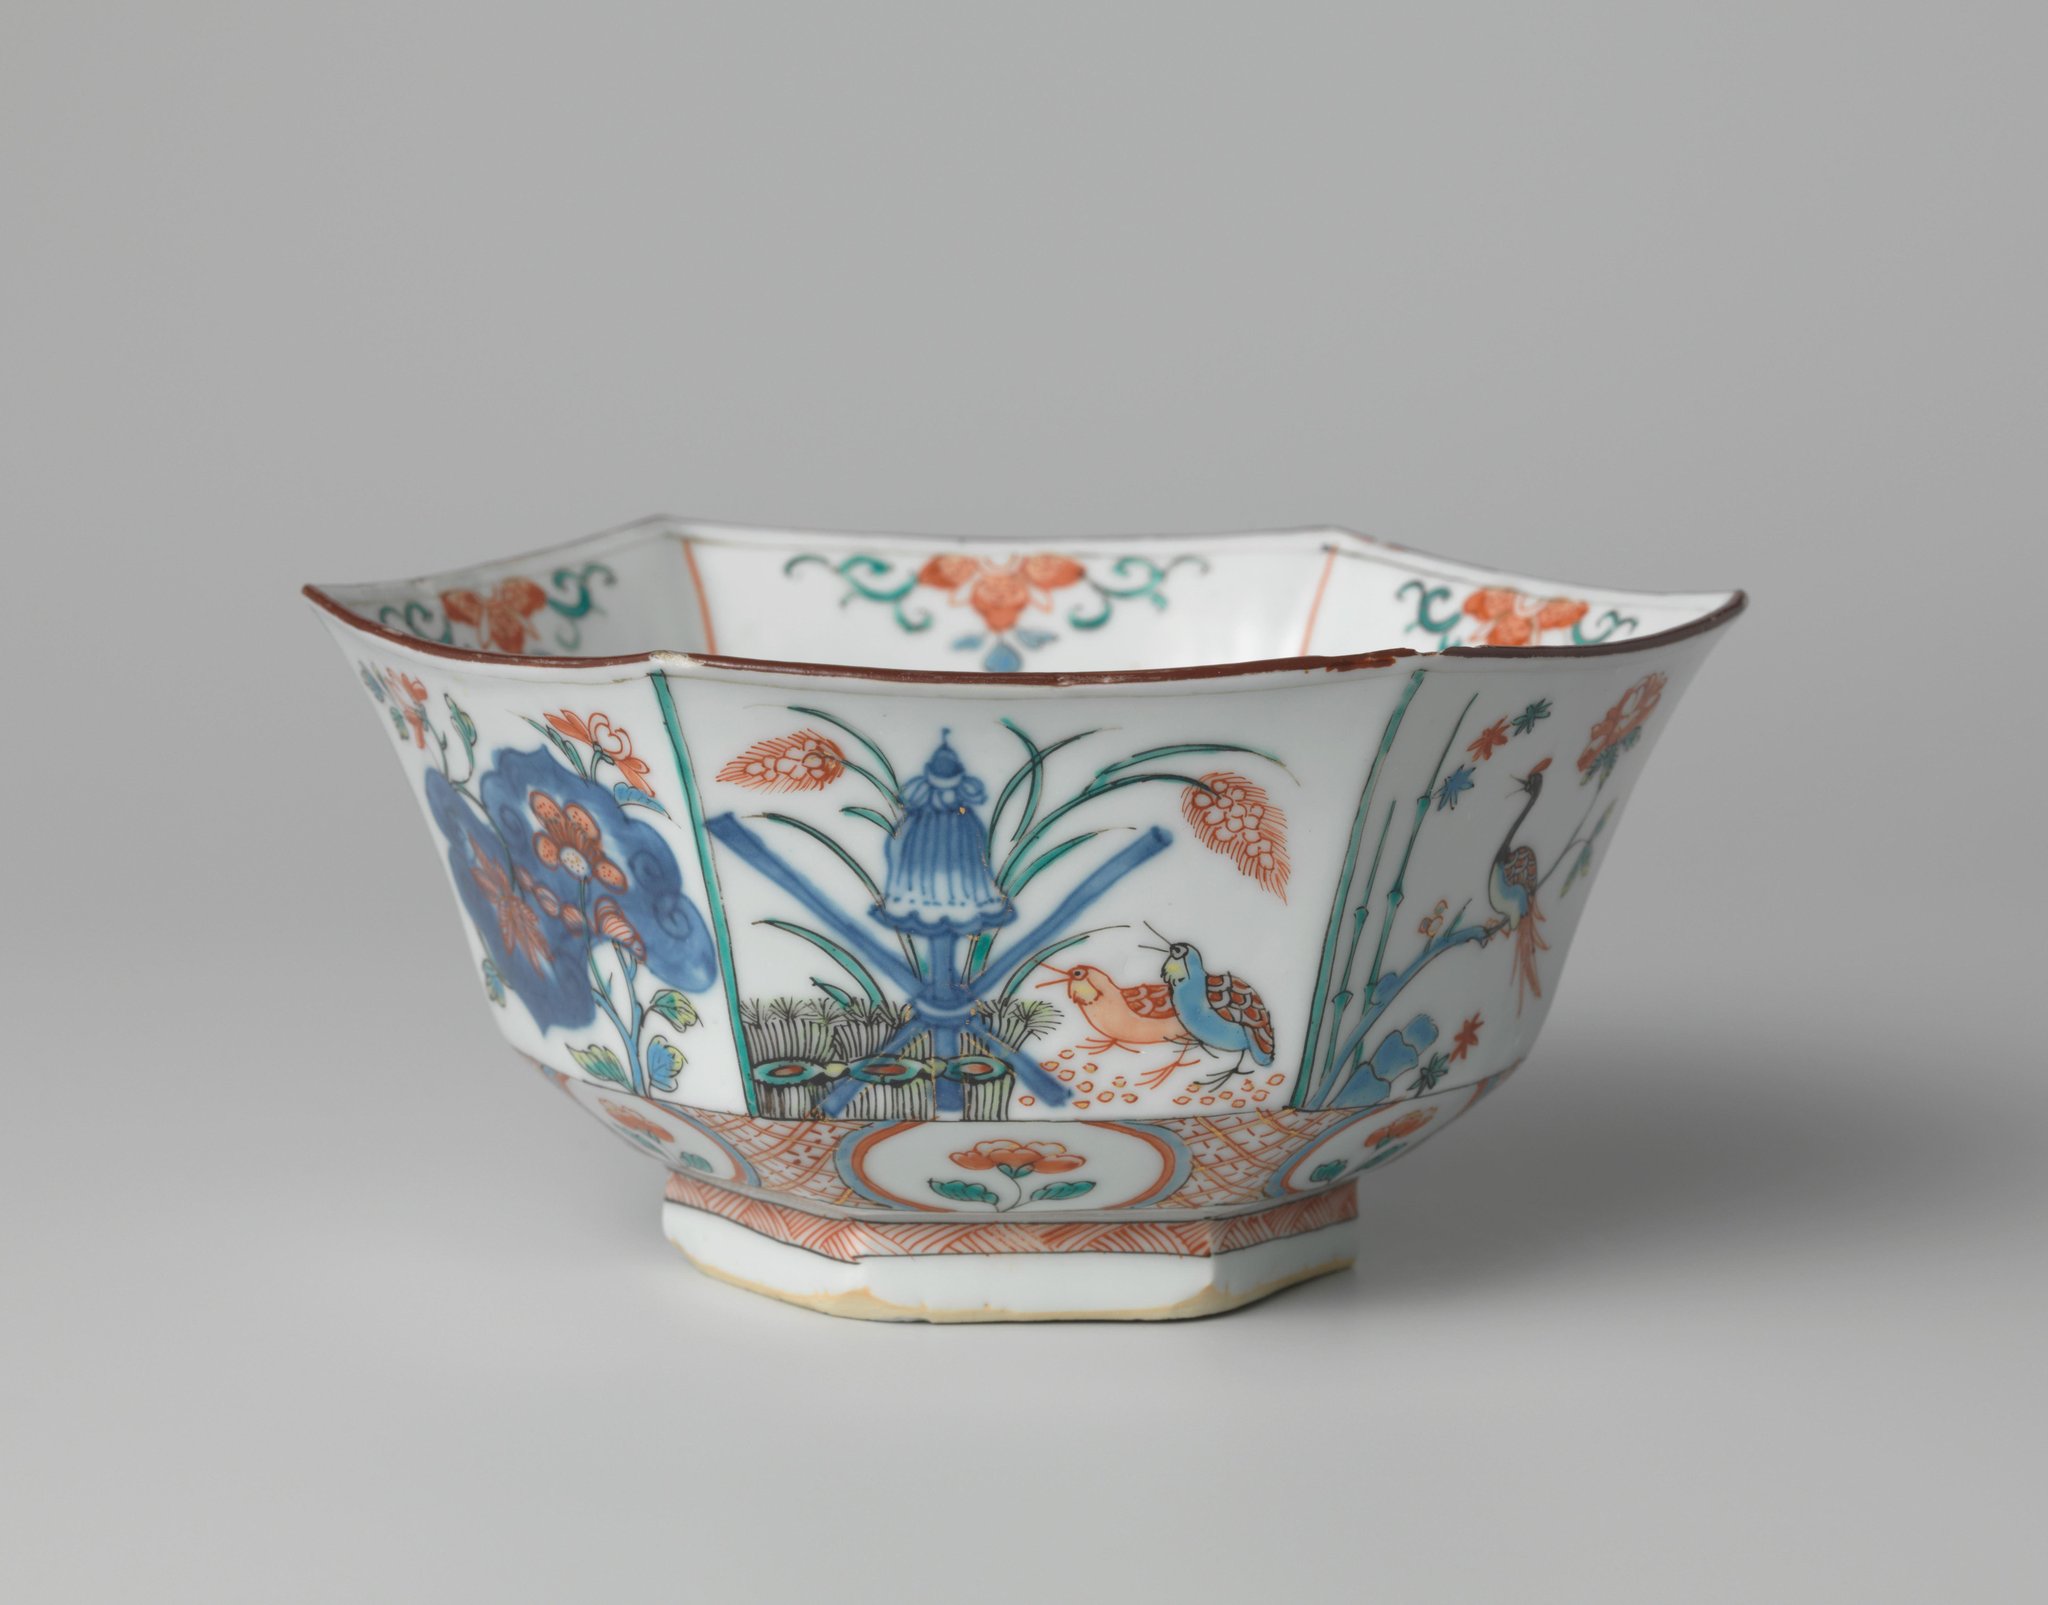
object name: bowl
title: Hexagonal bowl with flowering plants, birds and floral scrolls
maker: Anonymous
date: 1700-1724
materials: cobalt, glaze, gold, paint, porcelain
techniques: firing, forming, gilding, turning, vitrification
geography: china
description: Dish. China, c. 1700 - 1725, decorated, c. 1710 - 1725.